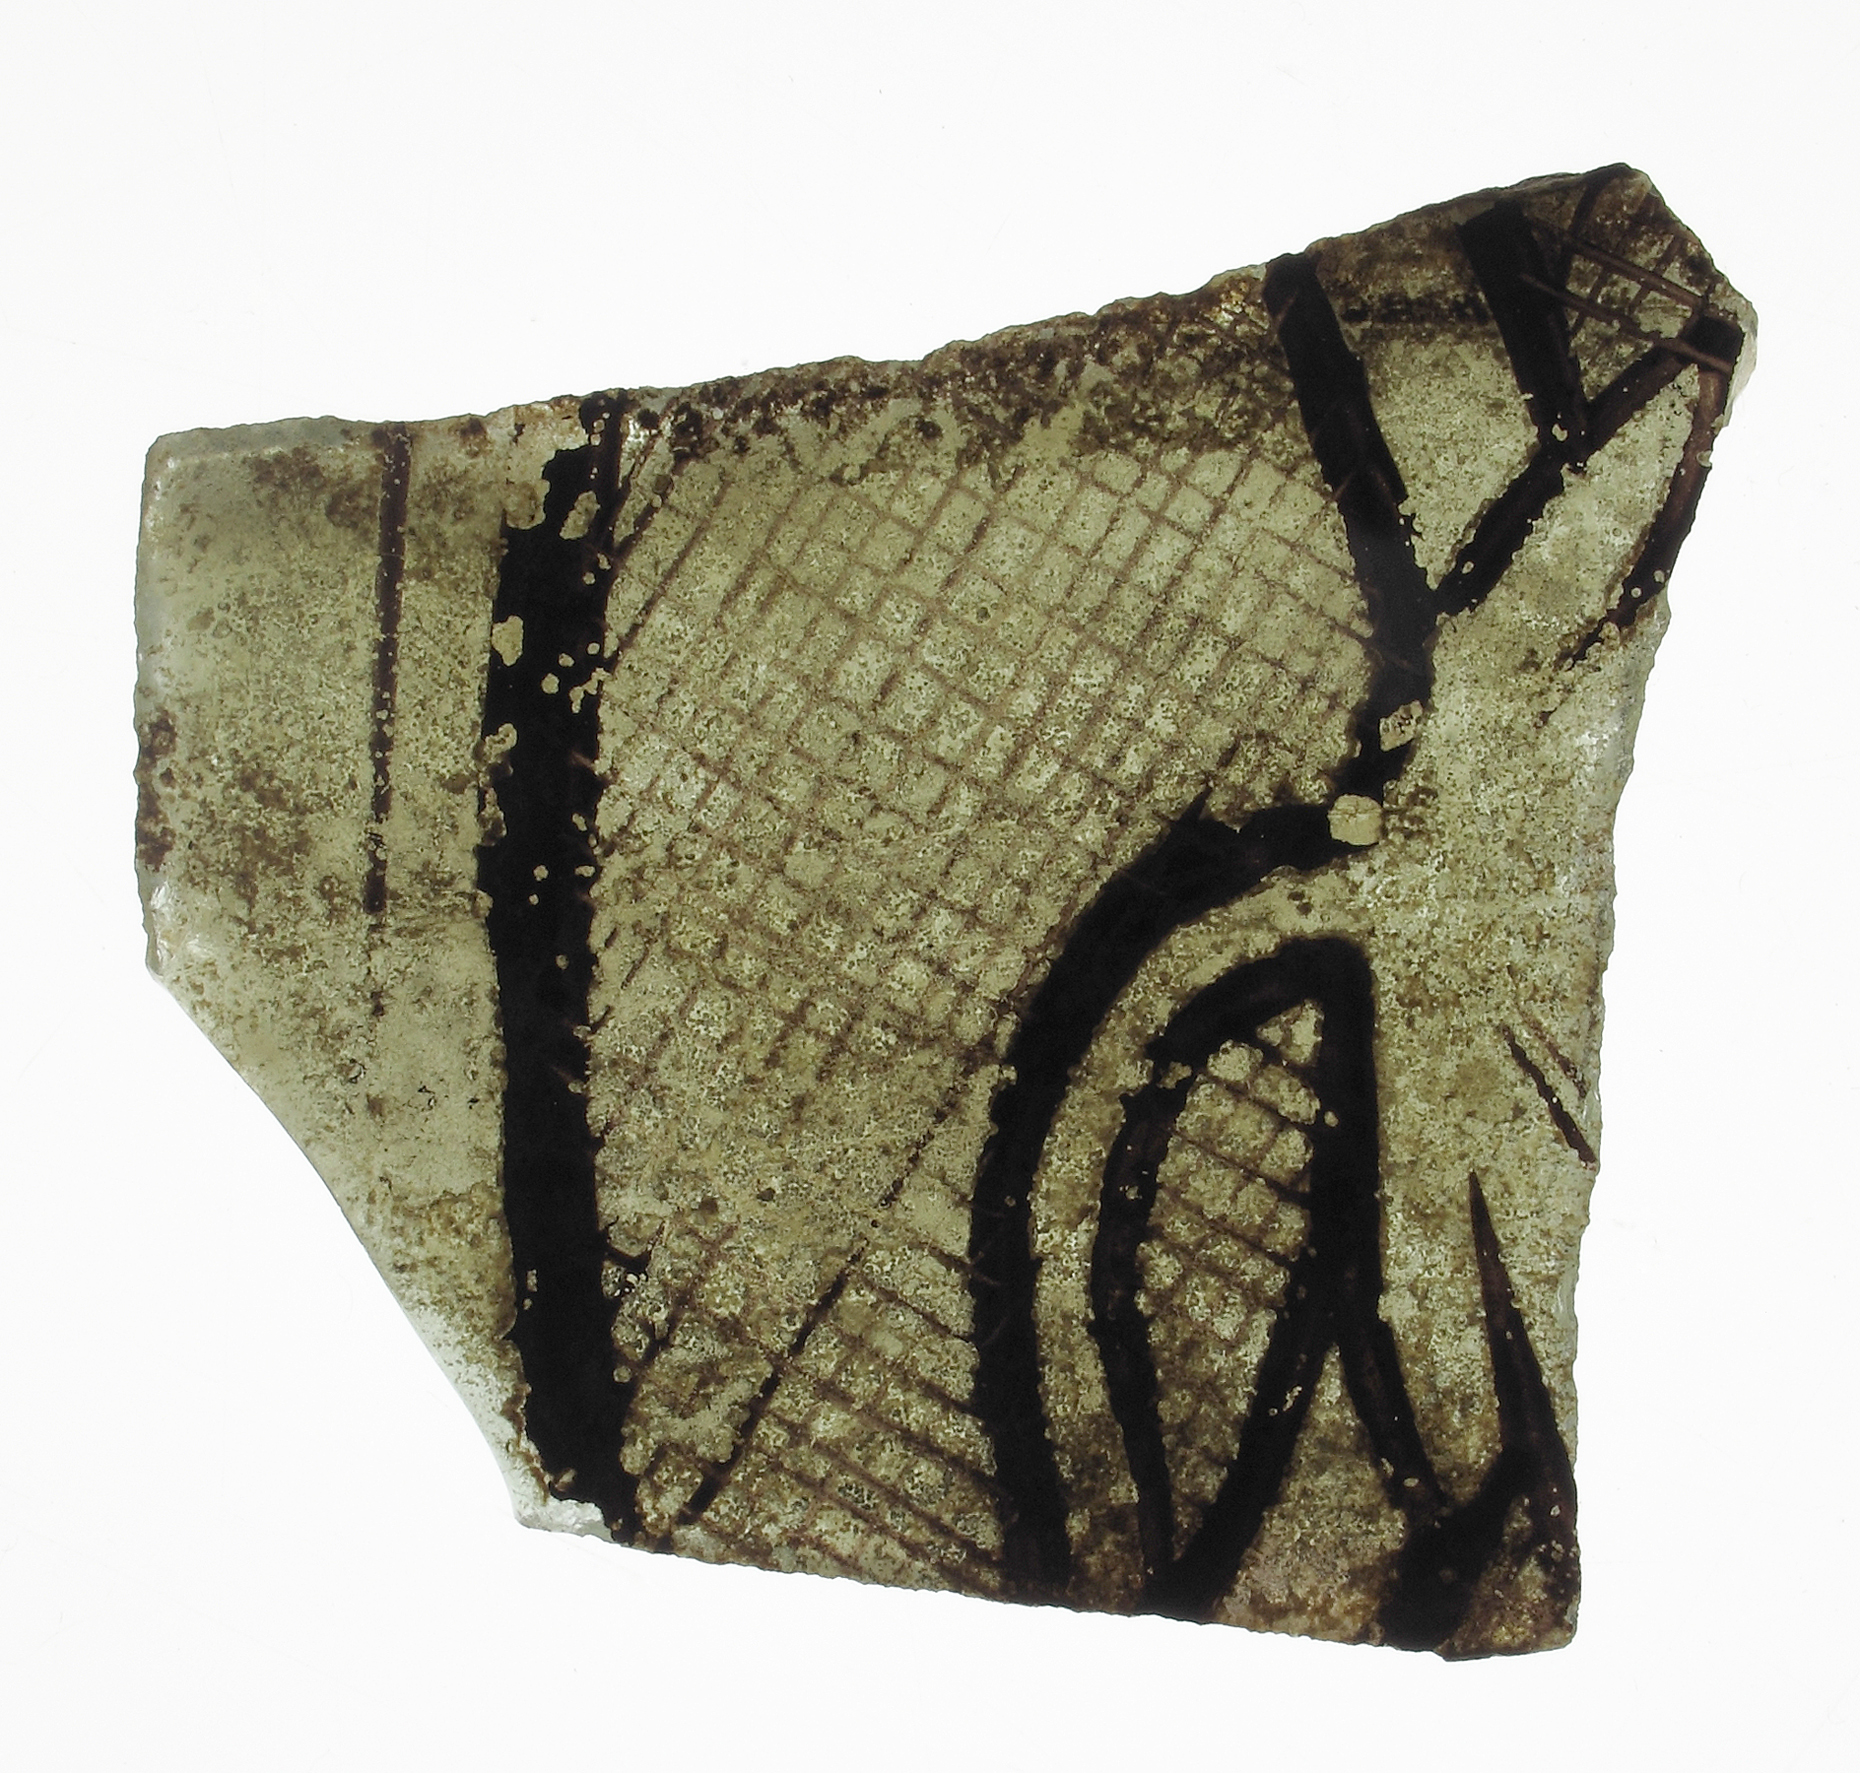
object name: fragment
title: Glass Fragment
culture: french or british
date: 1301-1333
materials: glass